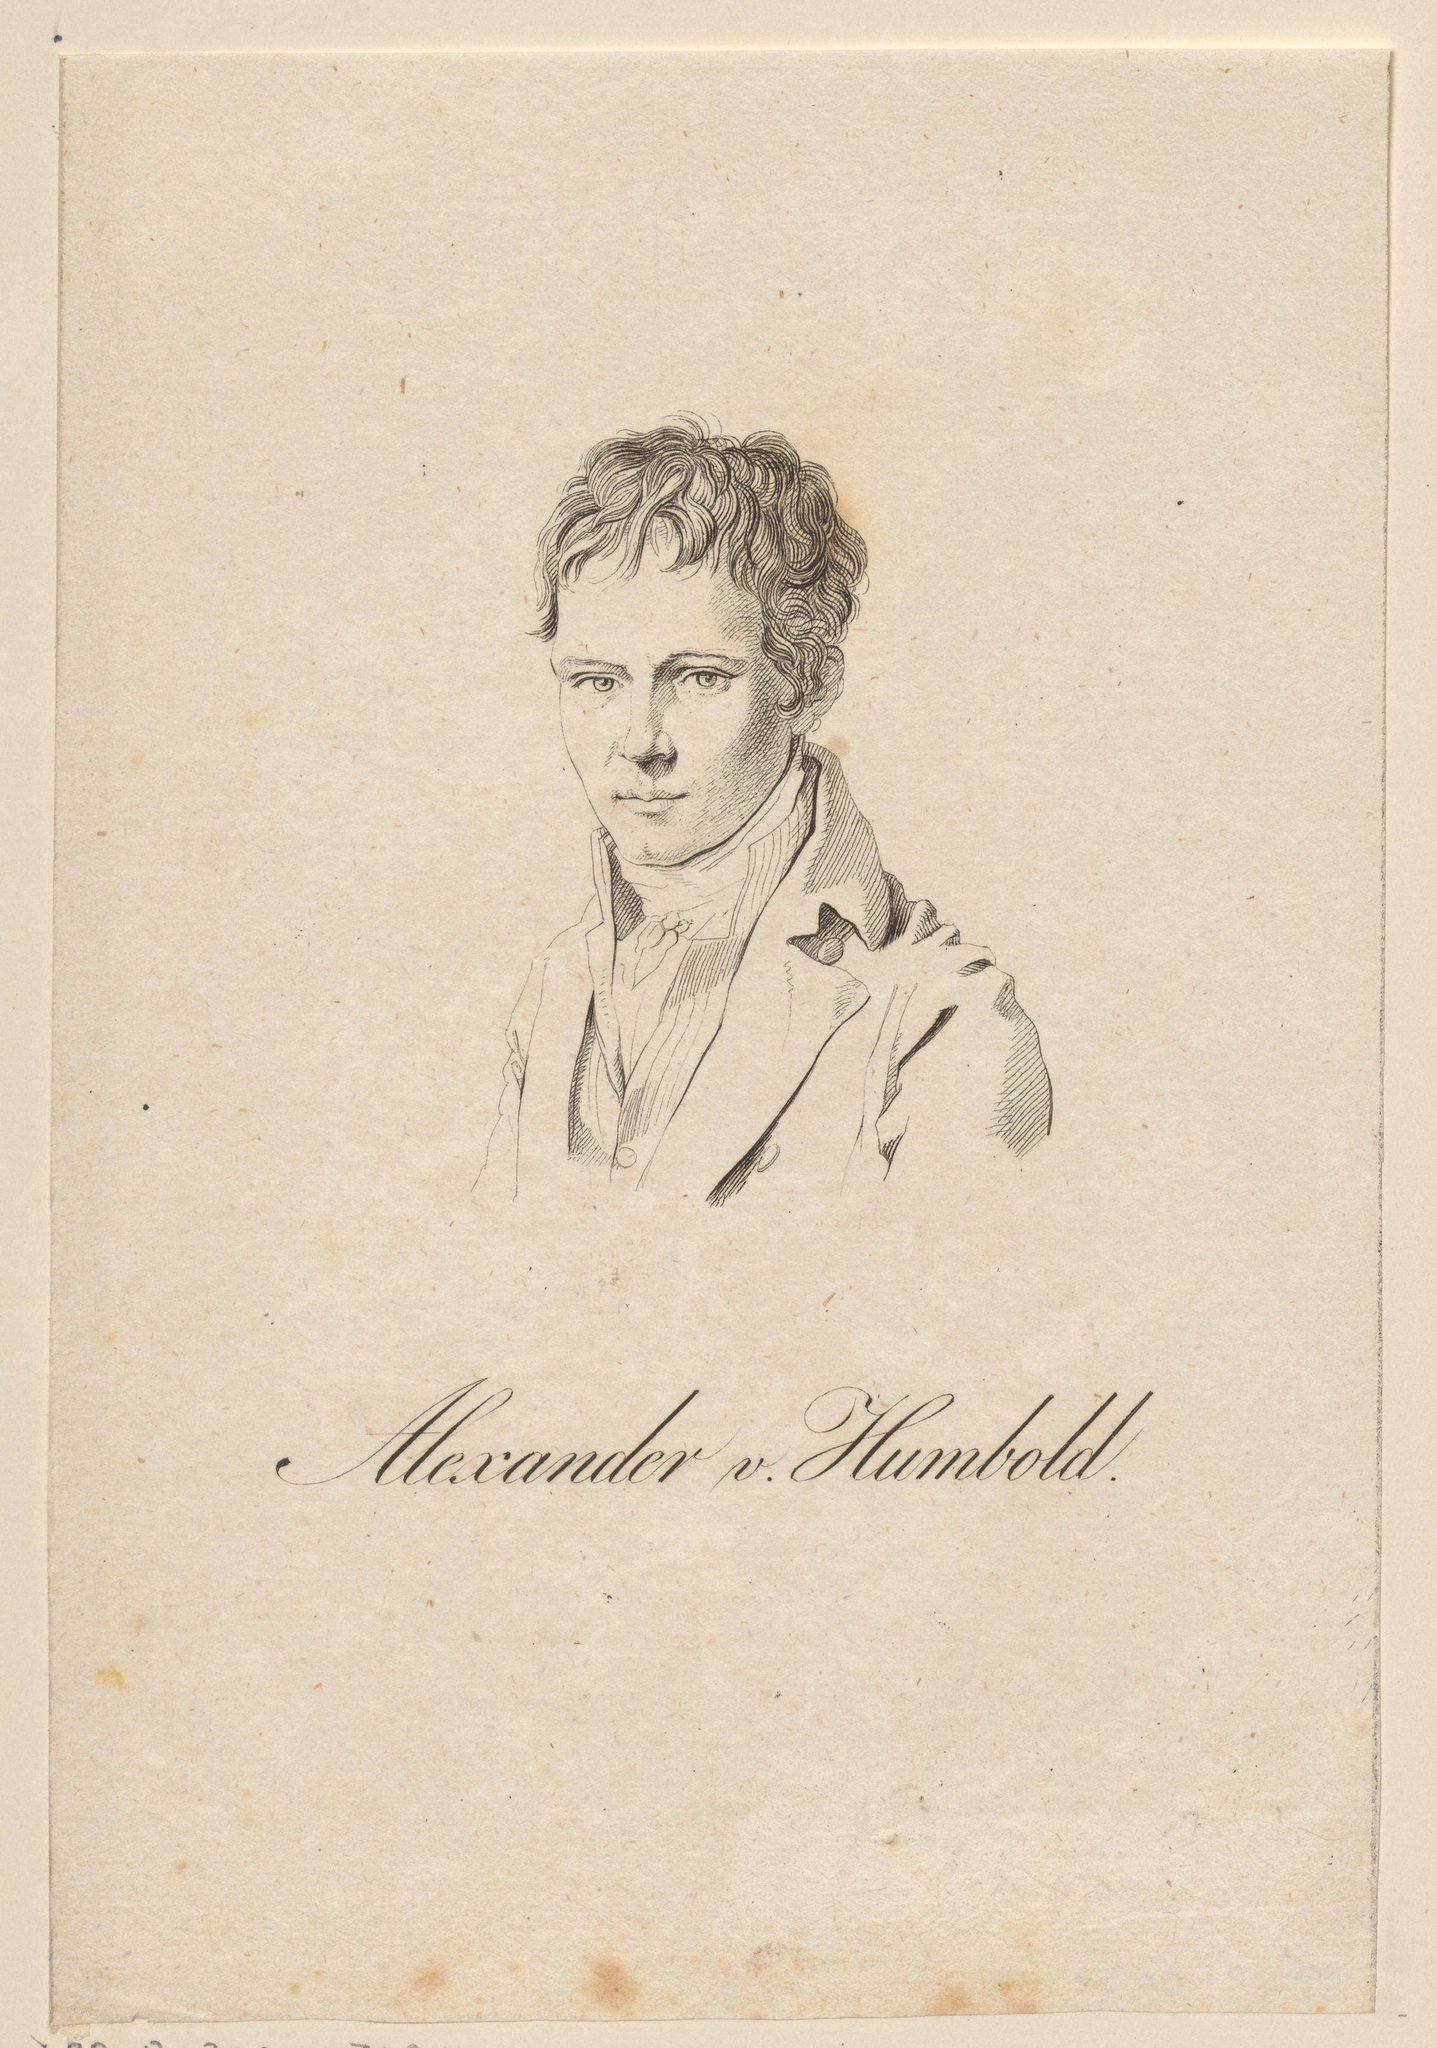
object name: print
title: Portret van Alexander von Humboldt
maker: Anonymous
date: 1800-1849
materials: paper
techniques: etching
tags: berlin, traveler, historical persons, biology (+ portrait of scholar, scientist)